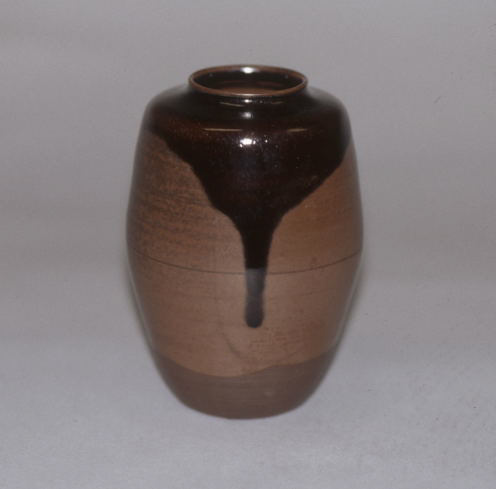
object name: tea jar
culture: japanese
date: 1701-1800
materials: clay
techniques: overglaze, underglaze